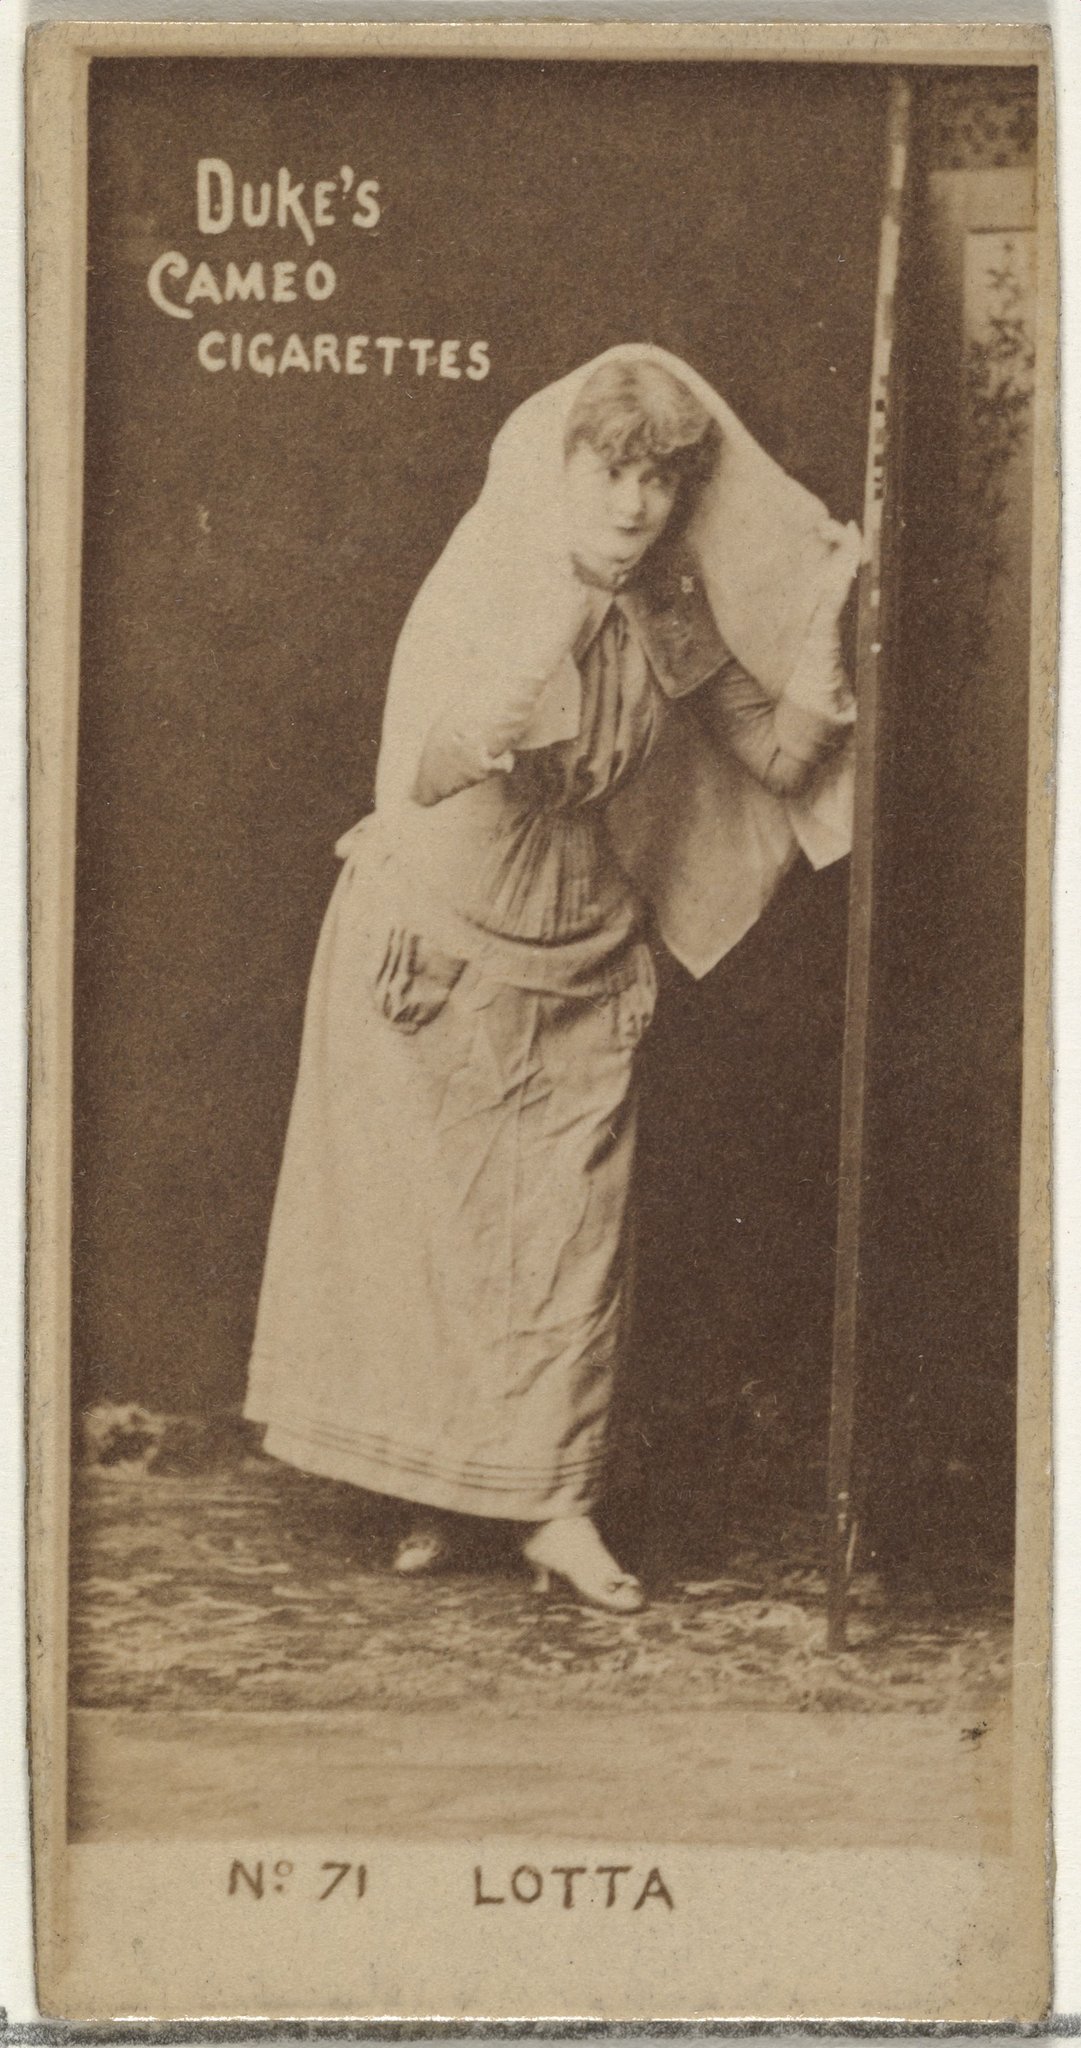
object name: photograph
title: Card Number 71, Lotta, from the Actors and Actresses series (N145-4) issued by Duke Sons & Co. to promote Cameo Cigarettes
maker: w. duke, sons & co.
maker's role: publisher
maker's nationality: american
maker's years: 1870-1920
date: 1880-1889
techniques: albumen silver print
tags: portraits,women,actresses